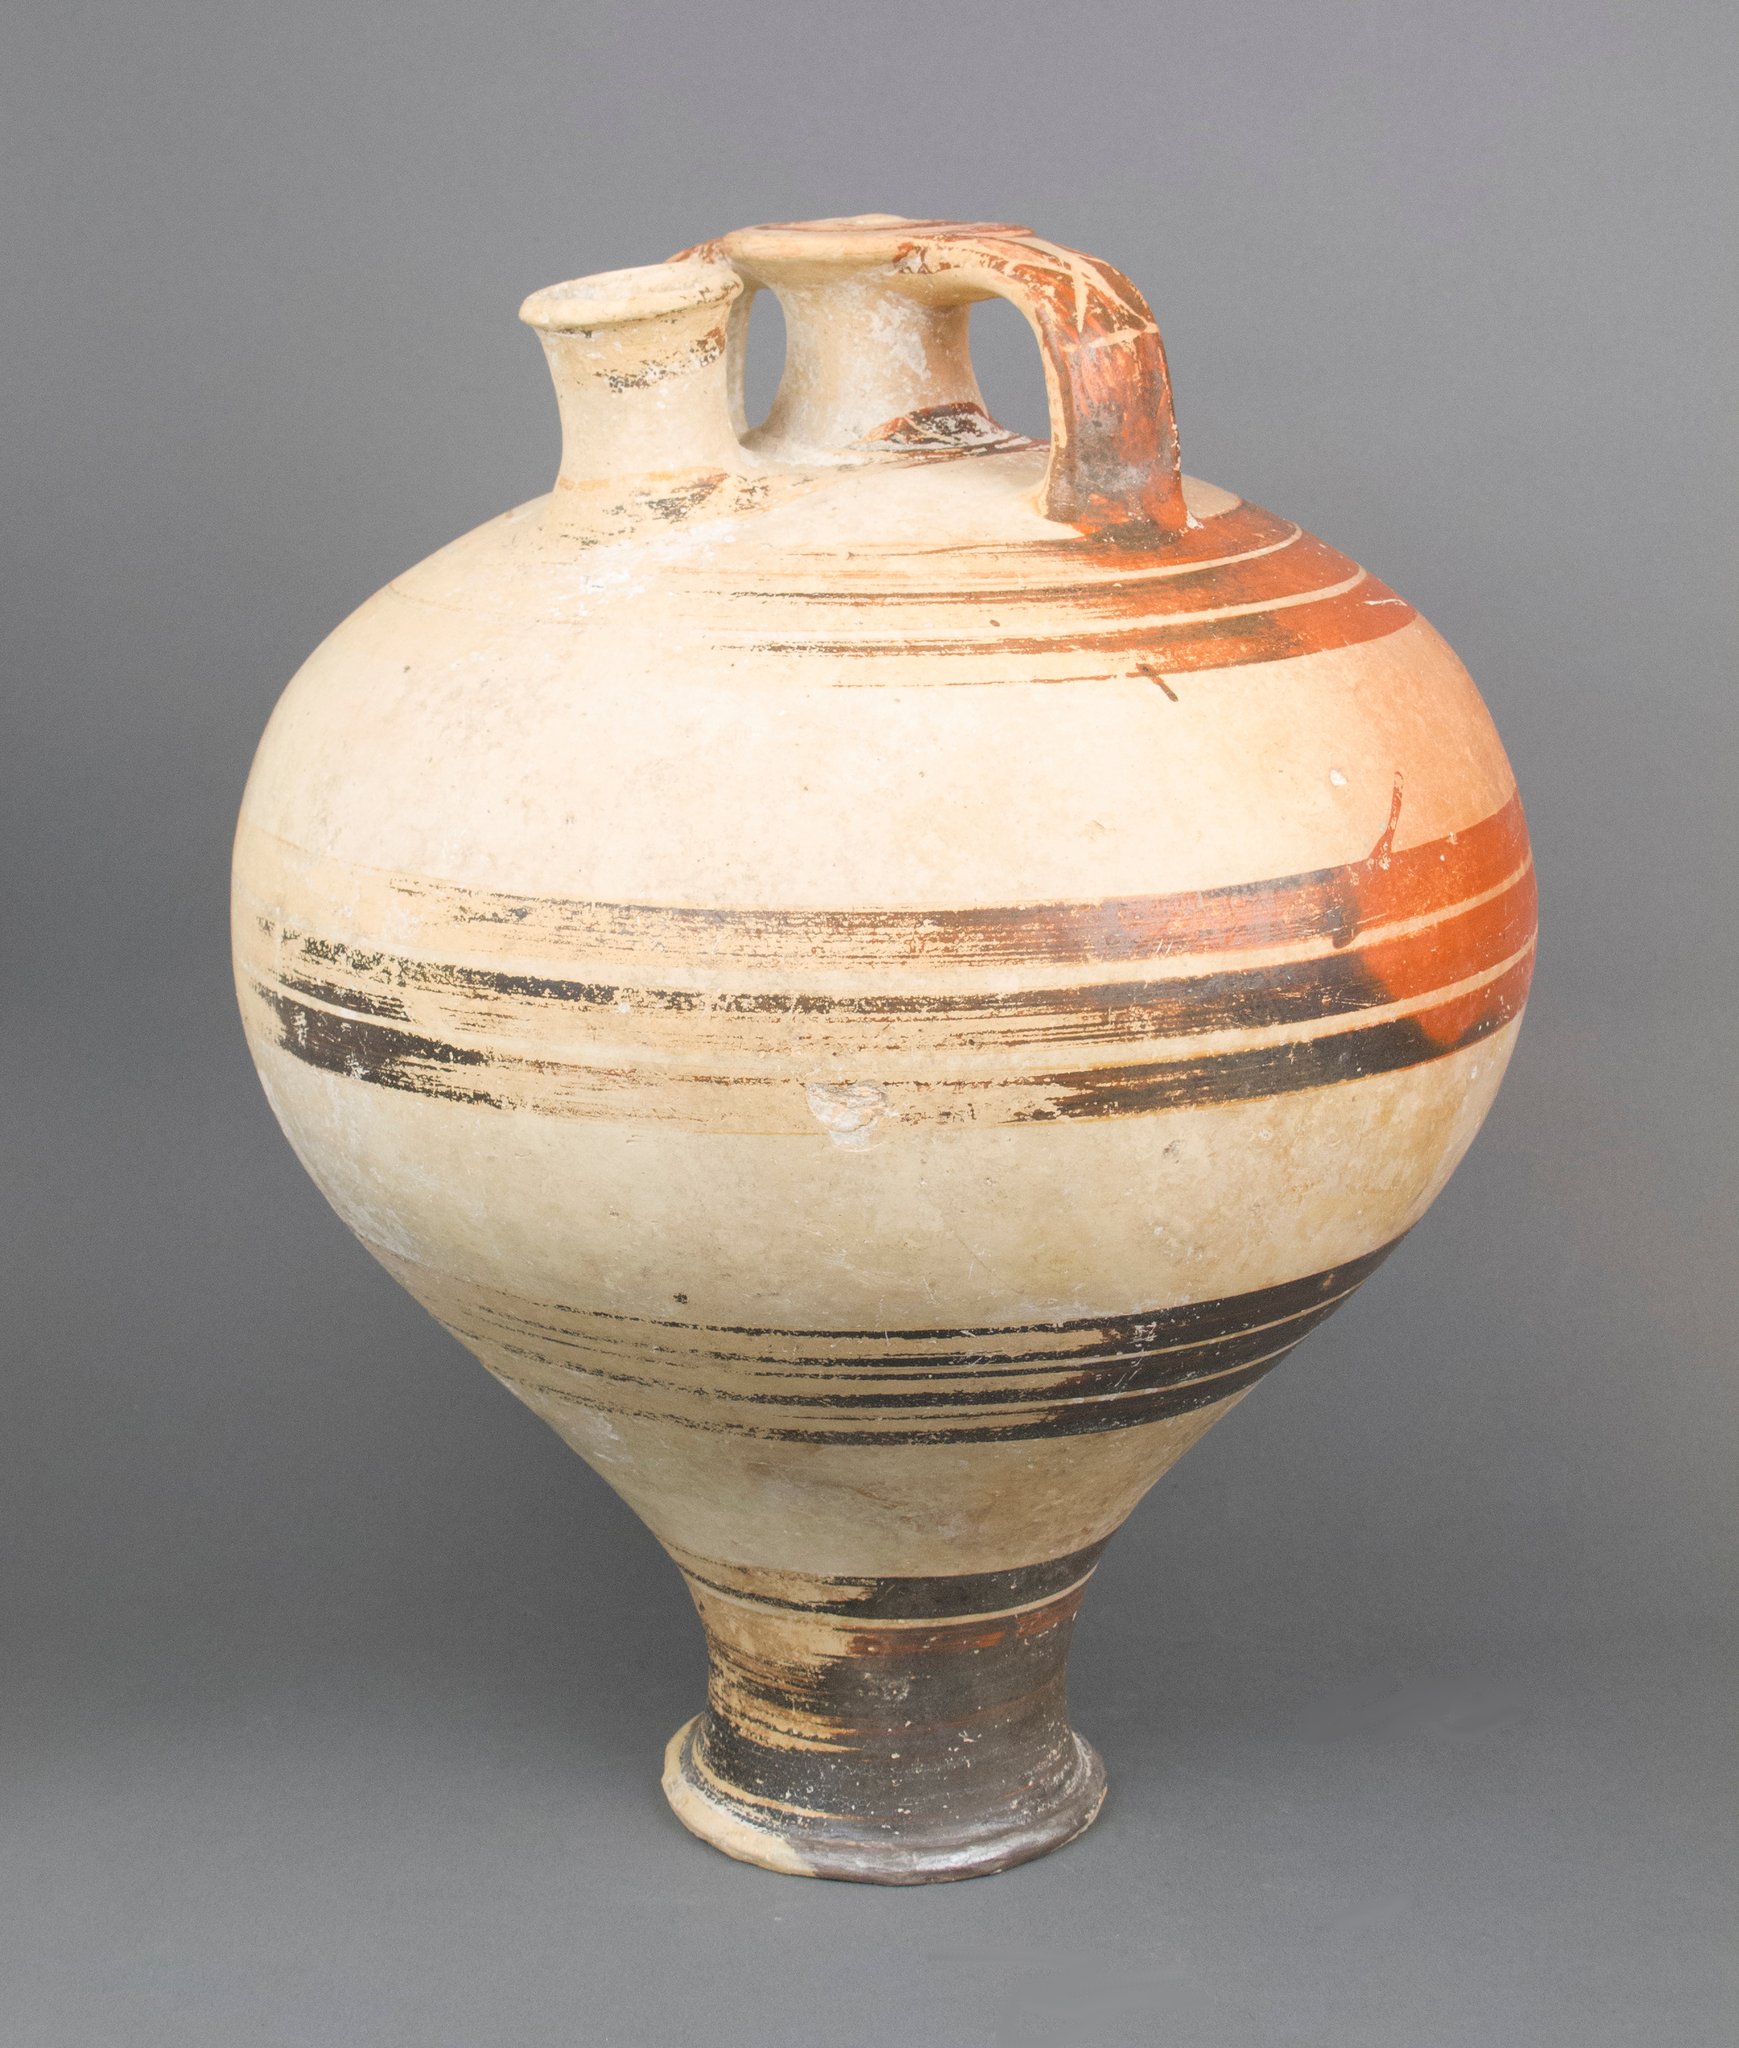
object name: stirrup jar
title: Terracotta stirrup jar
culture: aegean, helladic or mycenaean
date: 1200-1050 BCE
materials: terracotta